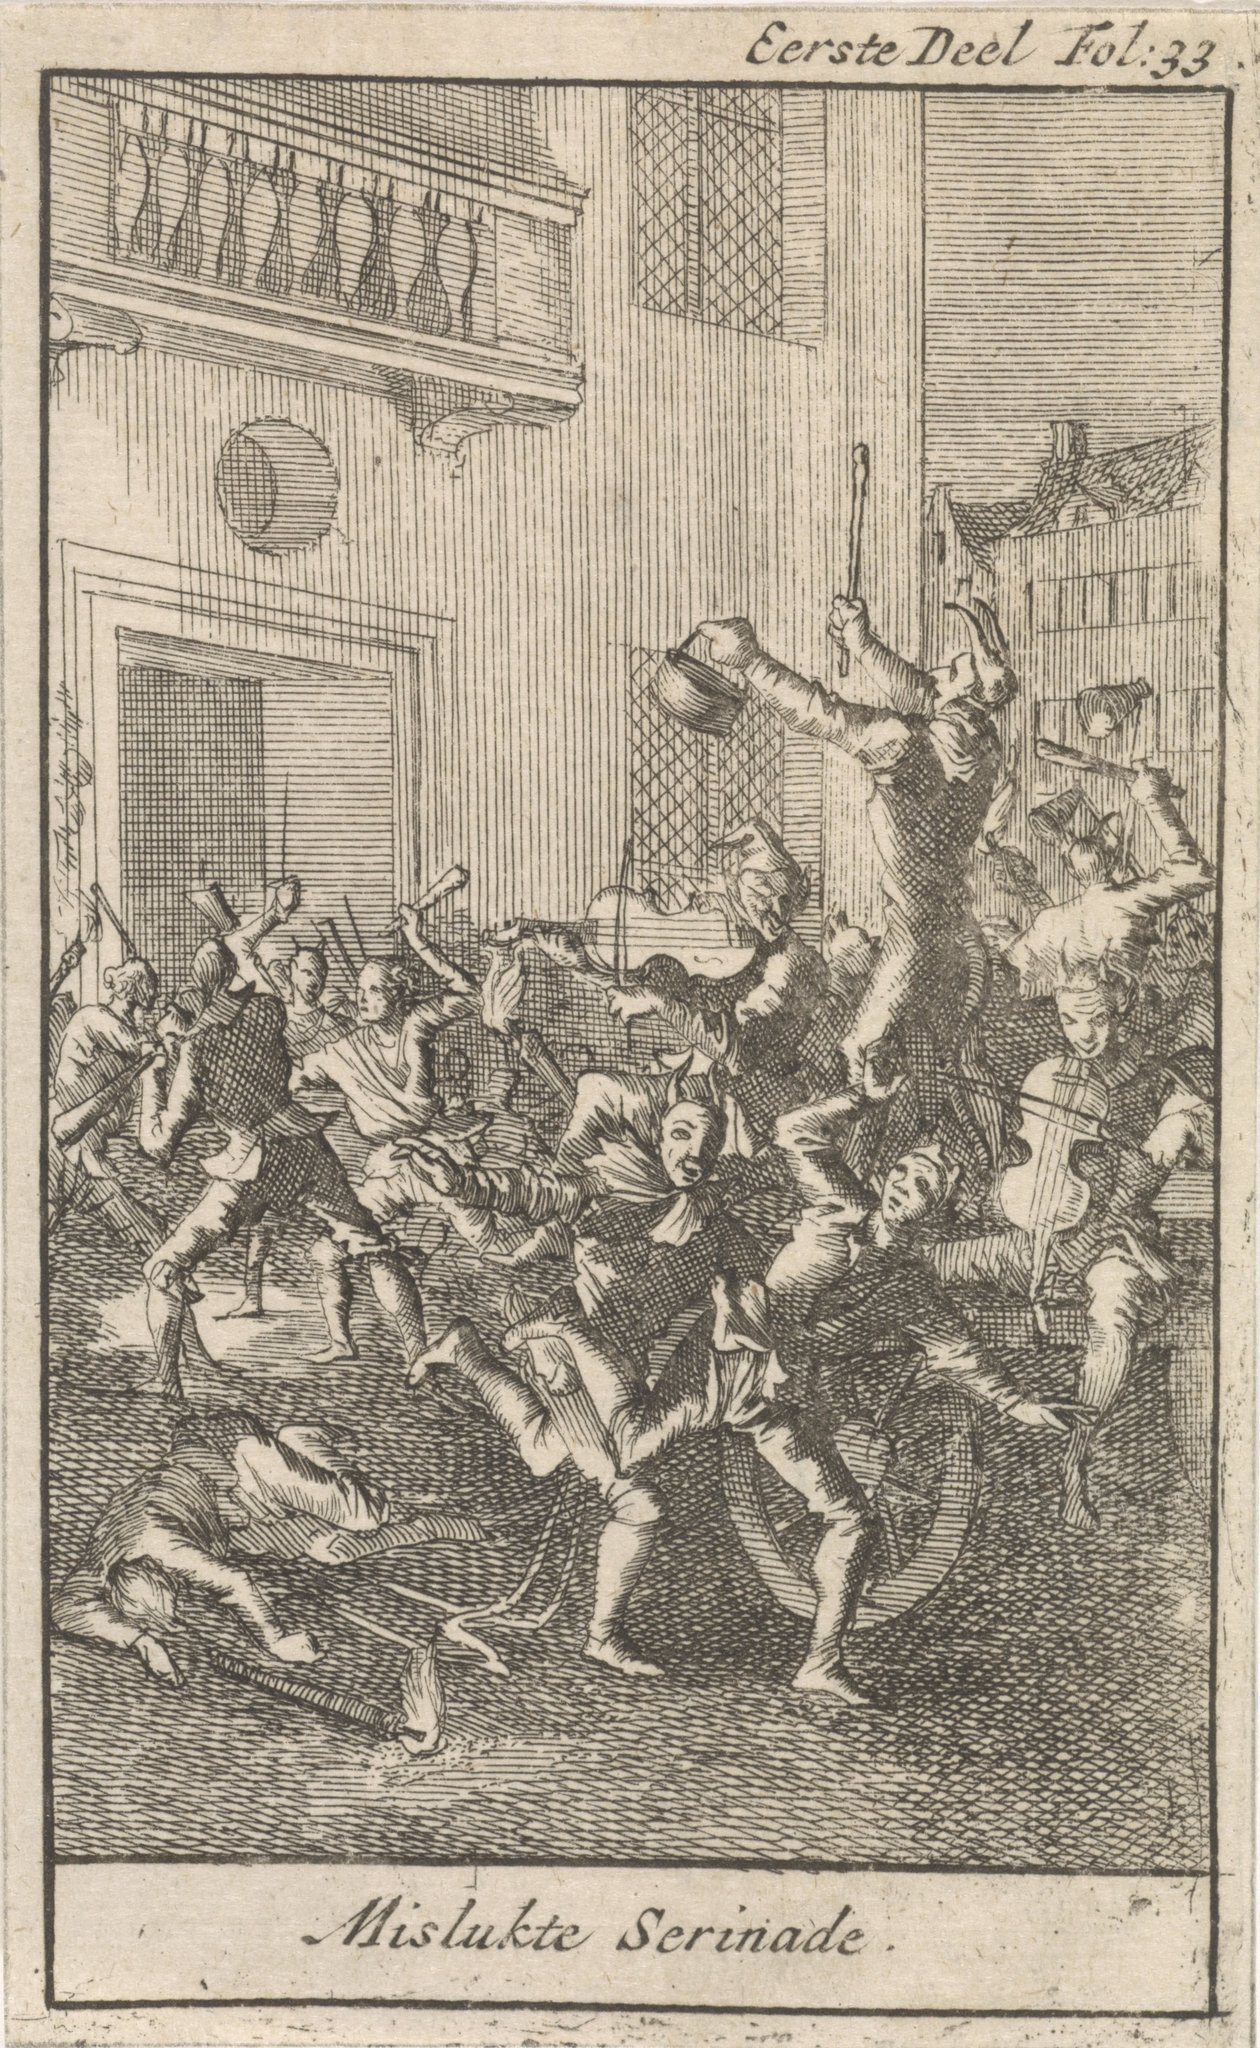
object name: book illustration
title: Nachtelijk gevecht met muzikanten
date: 1699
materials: paper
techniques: etching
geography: leiden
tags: court jester, court fool, street-fights, riots, more than one musician with instrument, serenade to the beloved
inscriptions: collector's mark: Lugt 2228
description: Op de voorgrond ontvluchten twee gemaskerde personen een gevecht. Achter hen een kar met muzikanten verkleed als duivels en narren die ketelmuziek maken. Deze muzikanten houden een serinade voor Faustina. Een scène uit het werk 'De nachtloper' van Francisco de Quevedo.